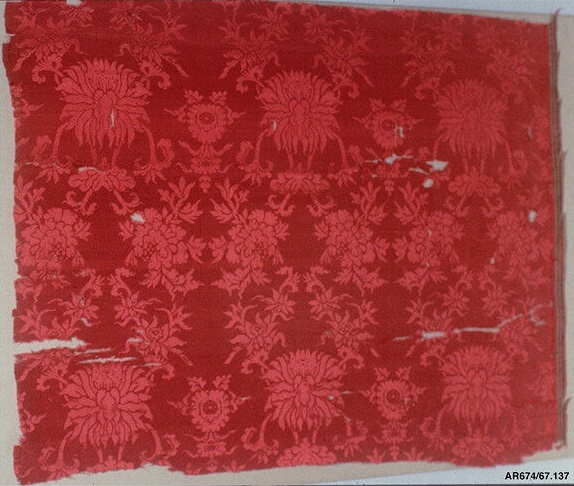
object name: piece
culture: chinese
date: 1601-1700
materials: silk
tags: flowers